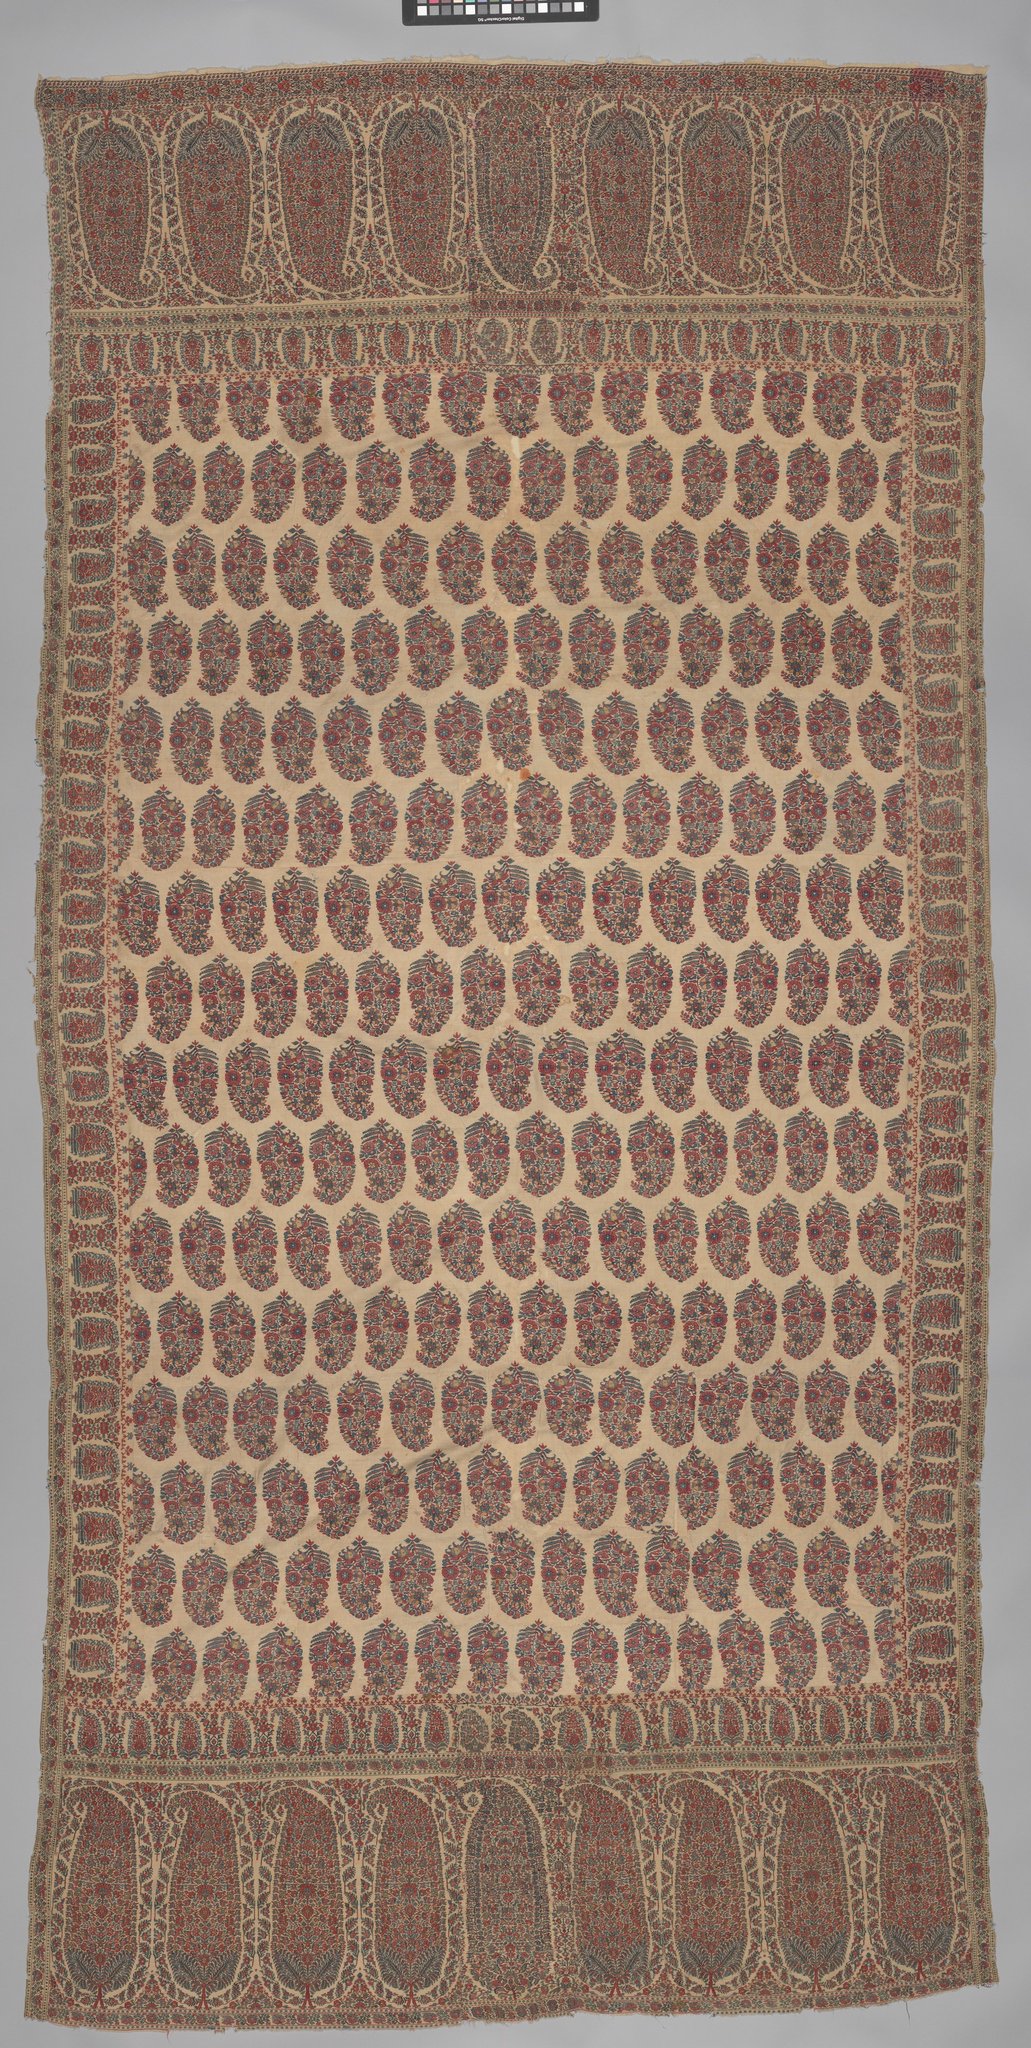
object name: shawl of joined fragment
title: Shawl of Joined Fragments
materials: wool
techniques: interlocking, weave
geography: india